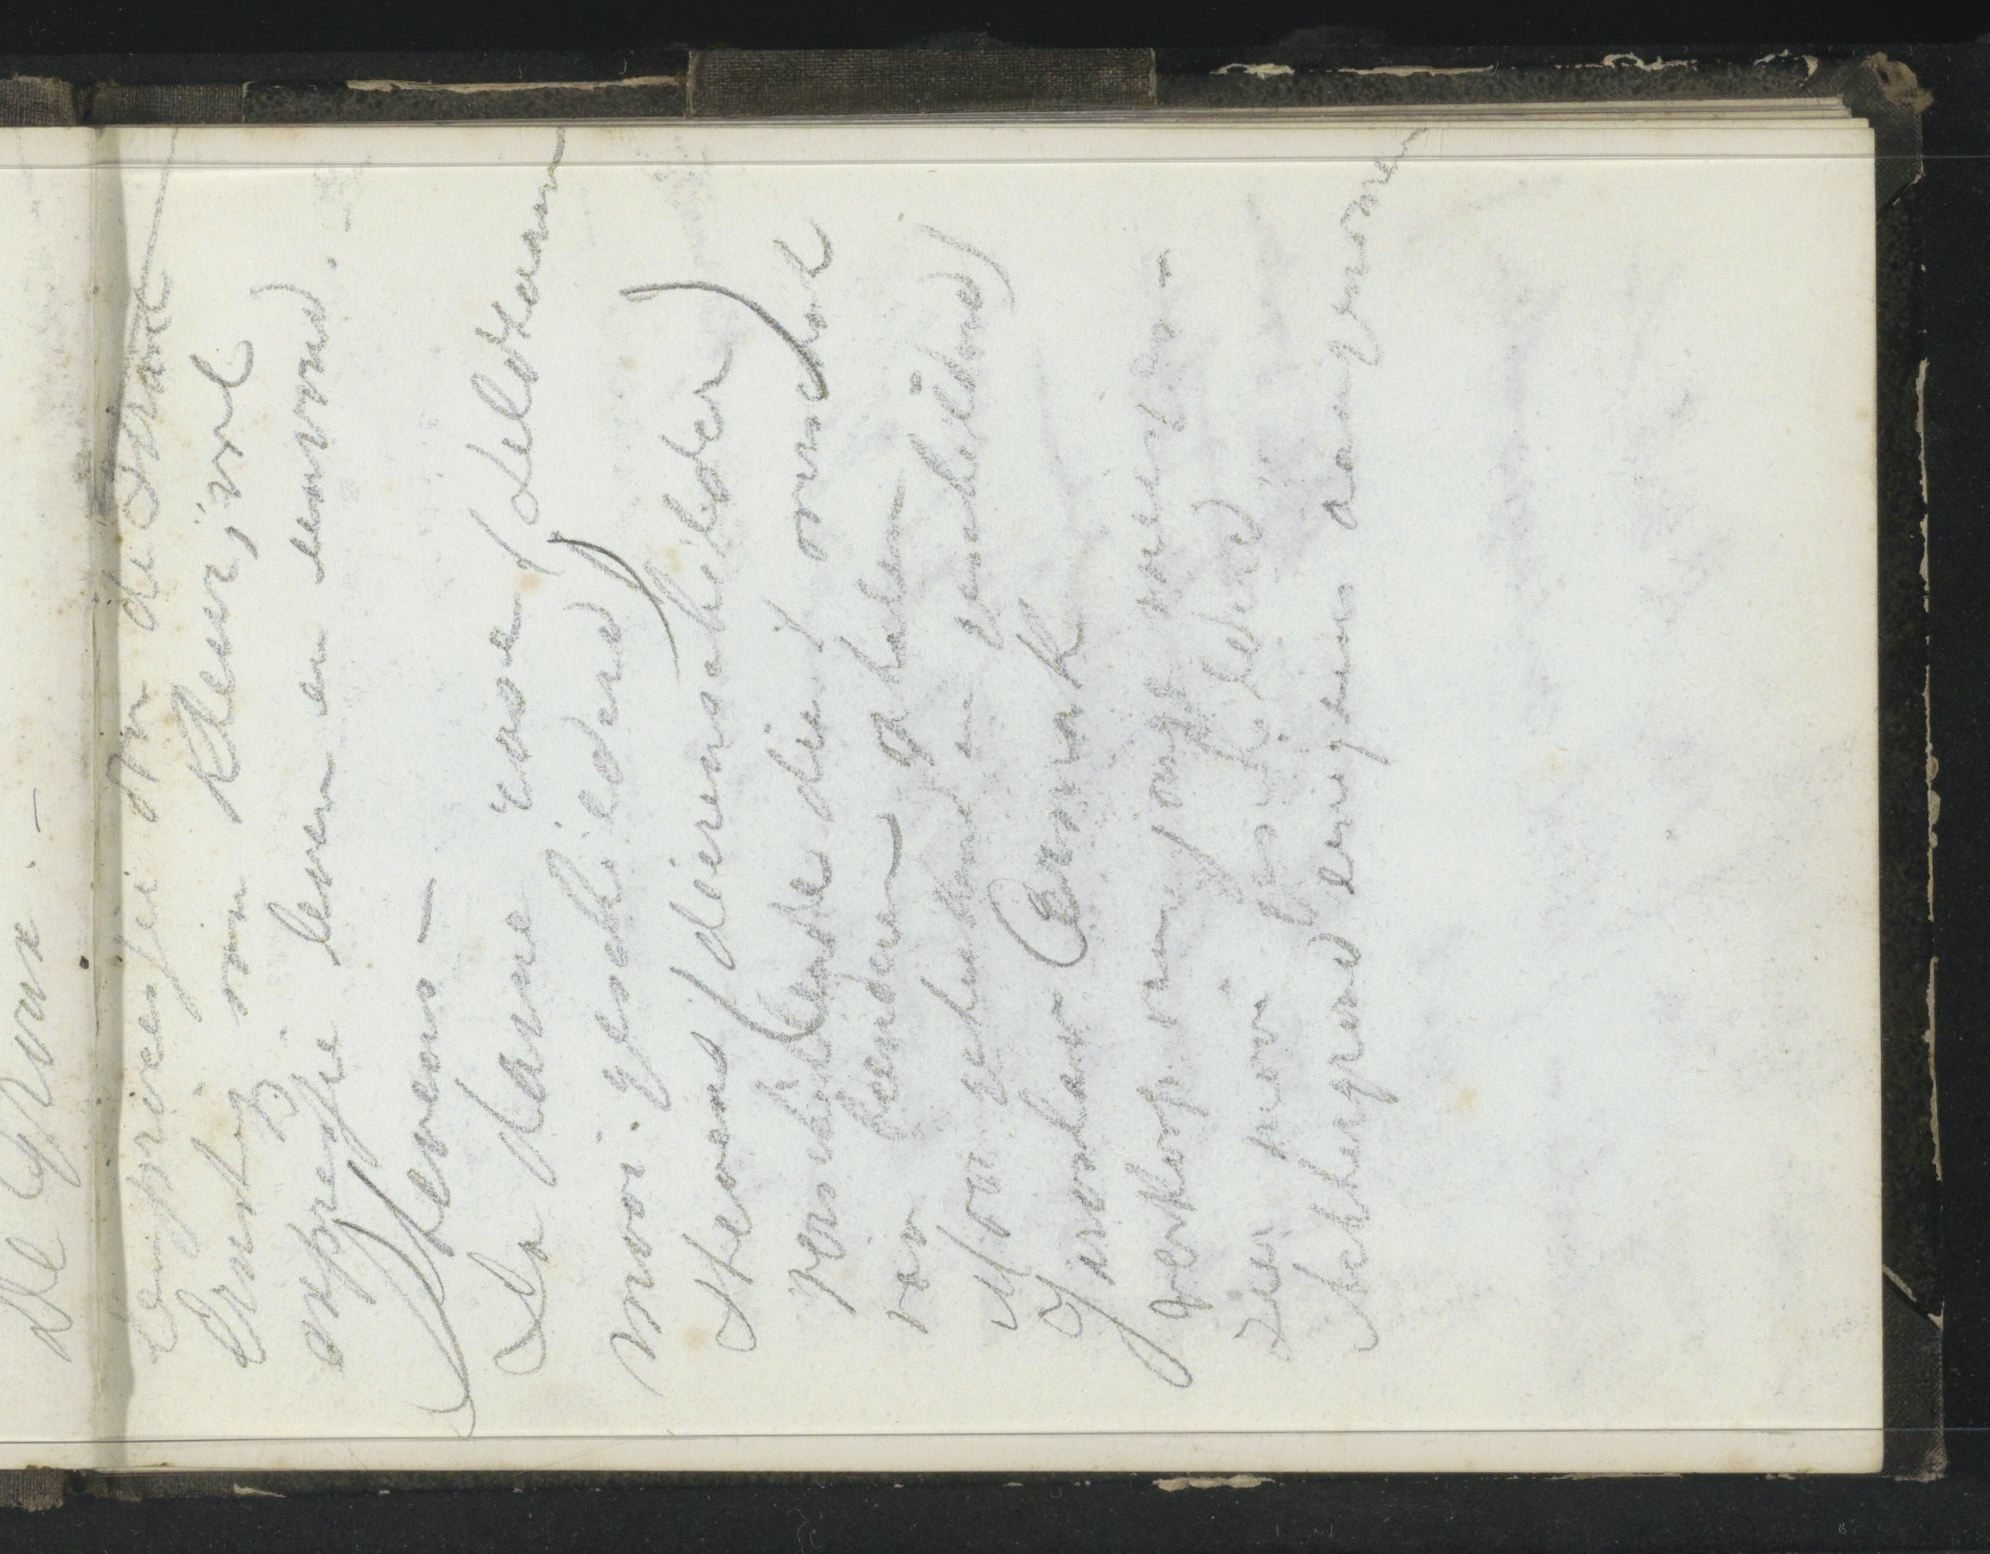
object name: sketchbook leaf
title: Notities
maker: theo hanrath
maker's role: draughtsman, painter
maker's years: 1853-1883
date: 1879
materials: paper, pencil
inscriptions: annotation: ‘namen van schilders en notities over hun werken’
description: Blad 5 recto uit een schetsboek met 27 bladen.